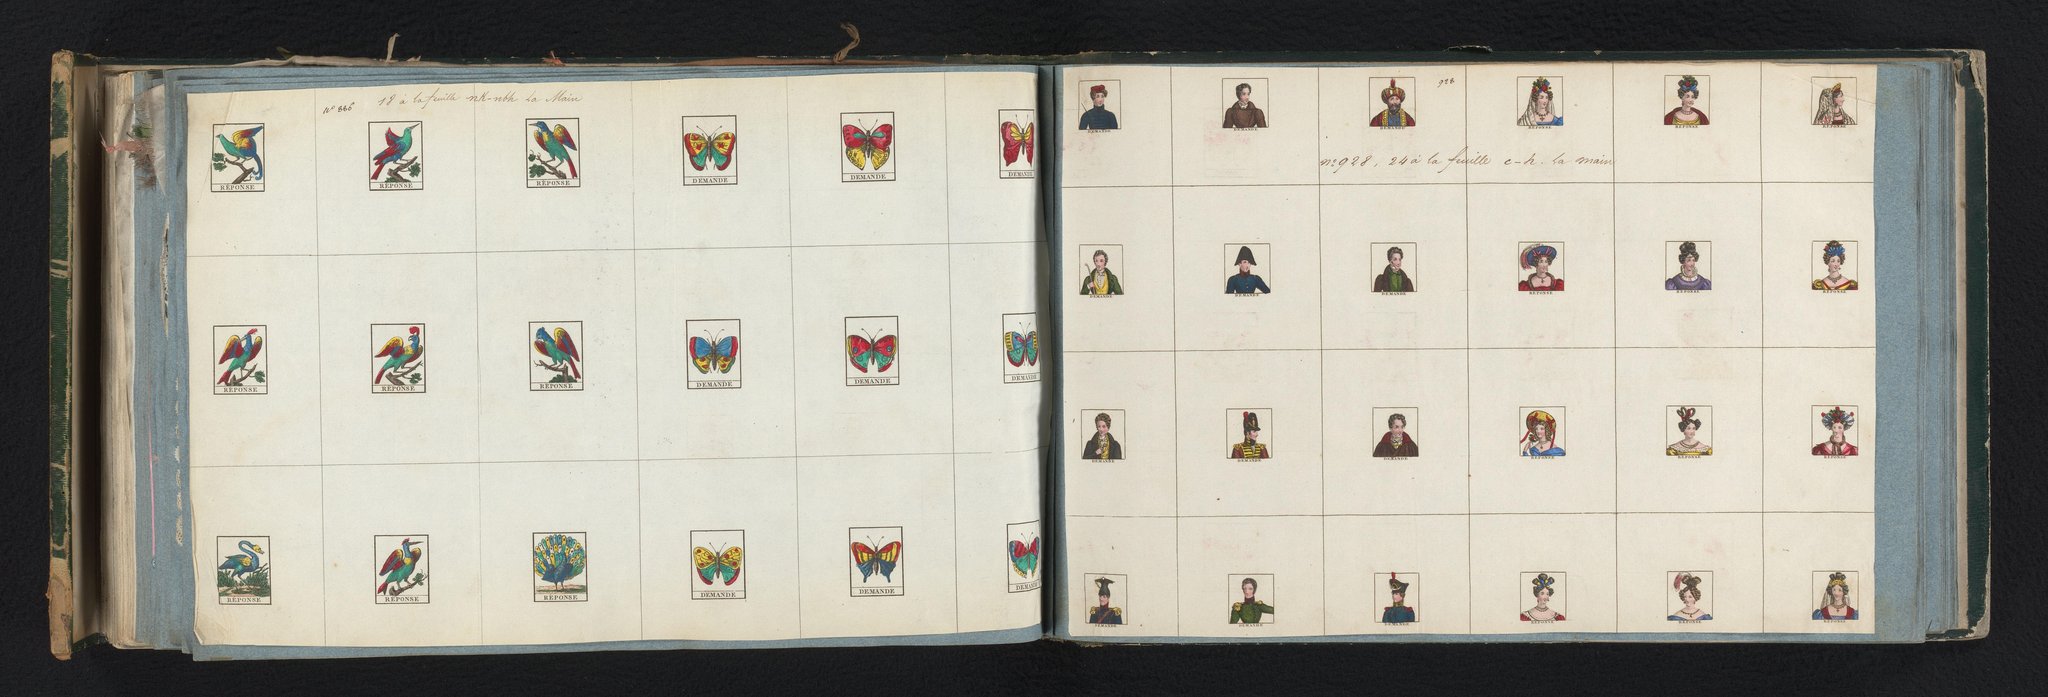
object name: sample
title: Twee bladzijden met bladen met vignetten met vlinders en vogels en mannen en vrouwen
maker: Anonymous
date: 1830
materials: ink, paper, watercolor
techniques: etching, hand coloring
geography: france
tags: birds, insects: butterfly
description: Twee bladzijden met links een ingeplakt blad waarop 18 gedrukte en ingekleurde vignetten van vogels met opschrift 'reponse' en vlinders met opschrift 'demande'. Rechts een ingeplakt blad met 24 gedrukte en ingekleurde vignetten van bustes van mannen met opschrift 'reponse' en vrouwen met opschrift 'demande'. Zonder de etiketten met nummers, maar de bladen genummerd 886 en 928 en voorzien van handgeschreven codes. Onderdeel van het stalenboek geschonken door de dames Van Rijn, vermoedelijk van een Franse papierfabrikant van luxe papieren, of diens vertegenwoordiger in Nederland, ca. 1830.